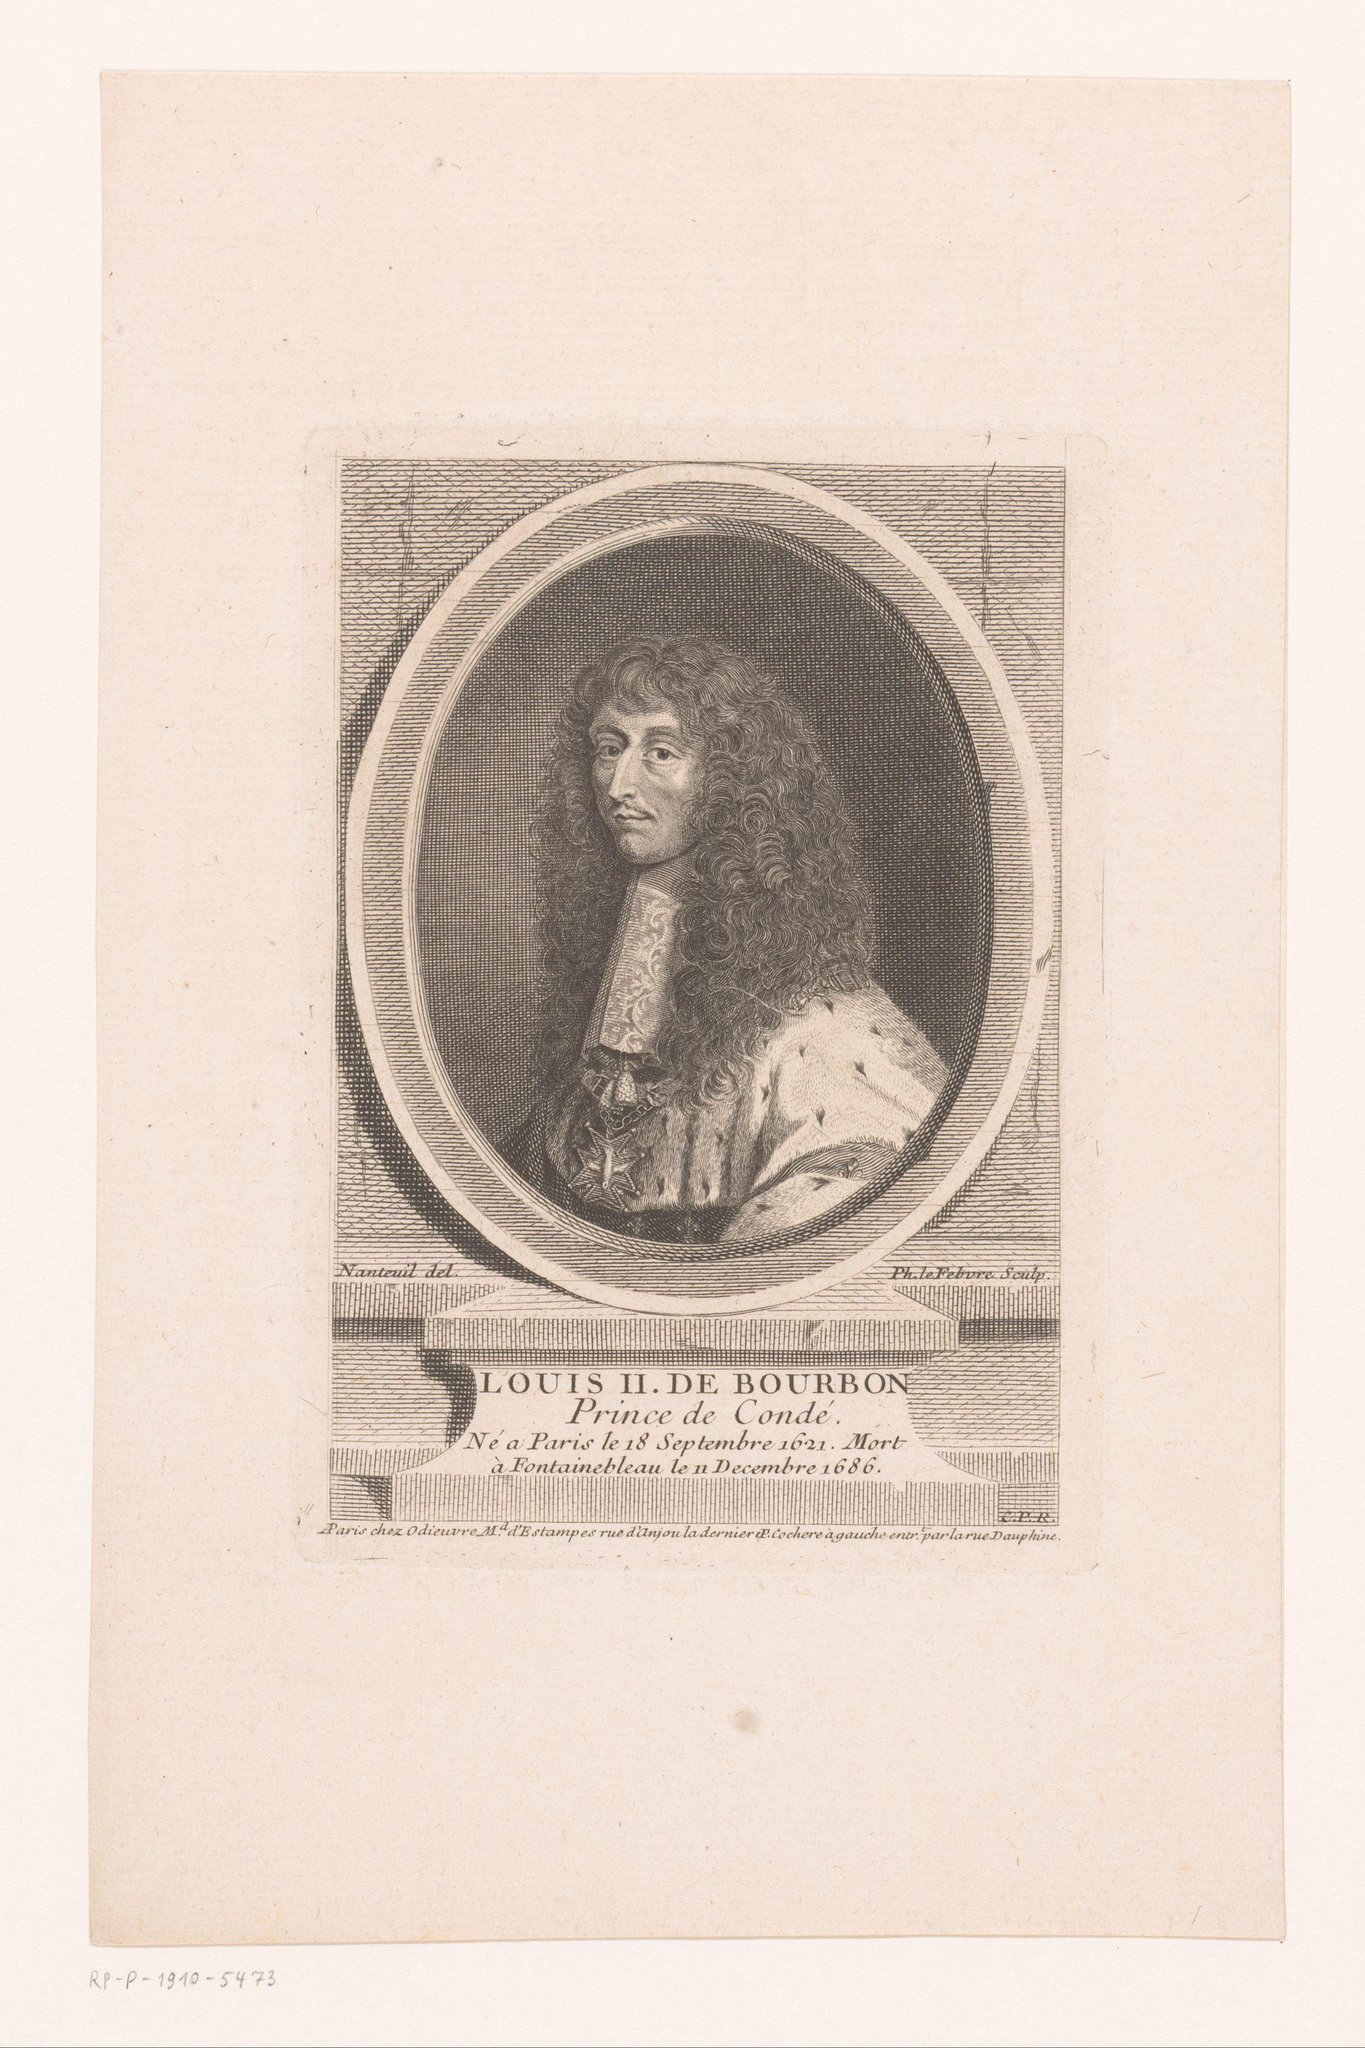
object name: print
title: Louis II. de Bourbon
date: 1755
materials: paper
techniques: engraving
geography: paris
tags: paris, lodewijk ii de bourbon-condé (hertog van enghien), ranks in the army, historical persons, nobility and patriciate; chivalry, knighthood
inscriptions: collector's mark: Lugt 2228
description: Prent uit: Dreux du Radier, Jean-François. L'Europe illustré, contenant l'histoire abregée des souverains, des princes, des prélats, des ministres, (...) en Europe: dans le XVe. siècle compris, jusqu'à présent. Parijs: Michel Odieuvre en Jean-Luc Nyon, 1755, dl. 2, p. 119.